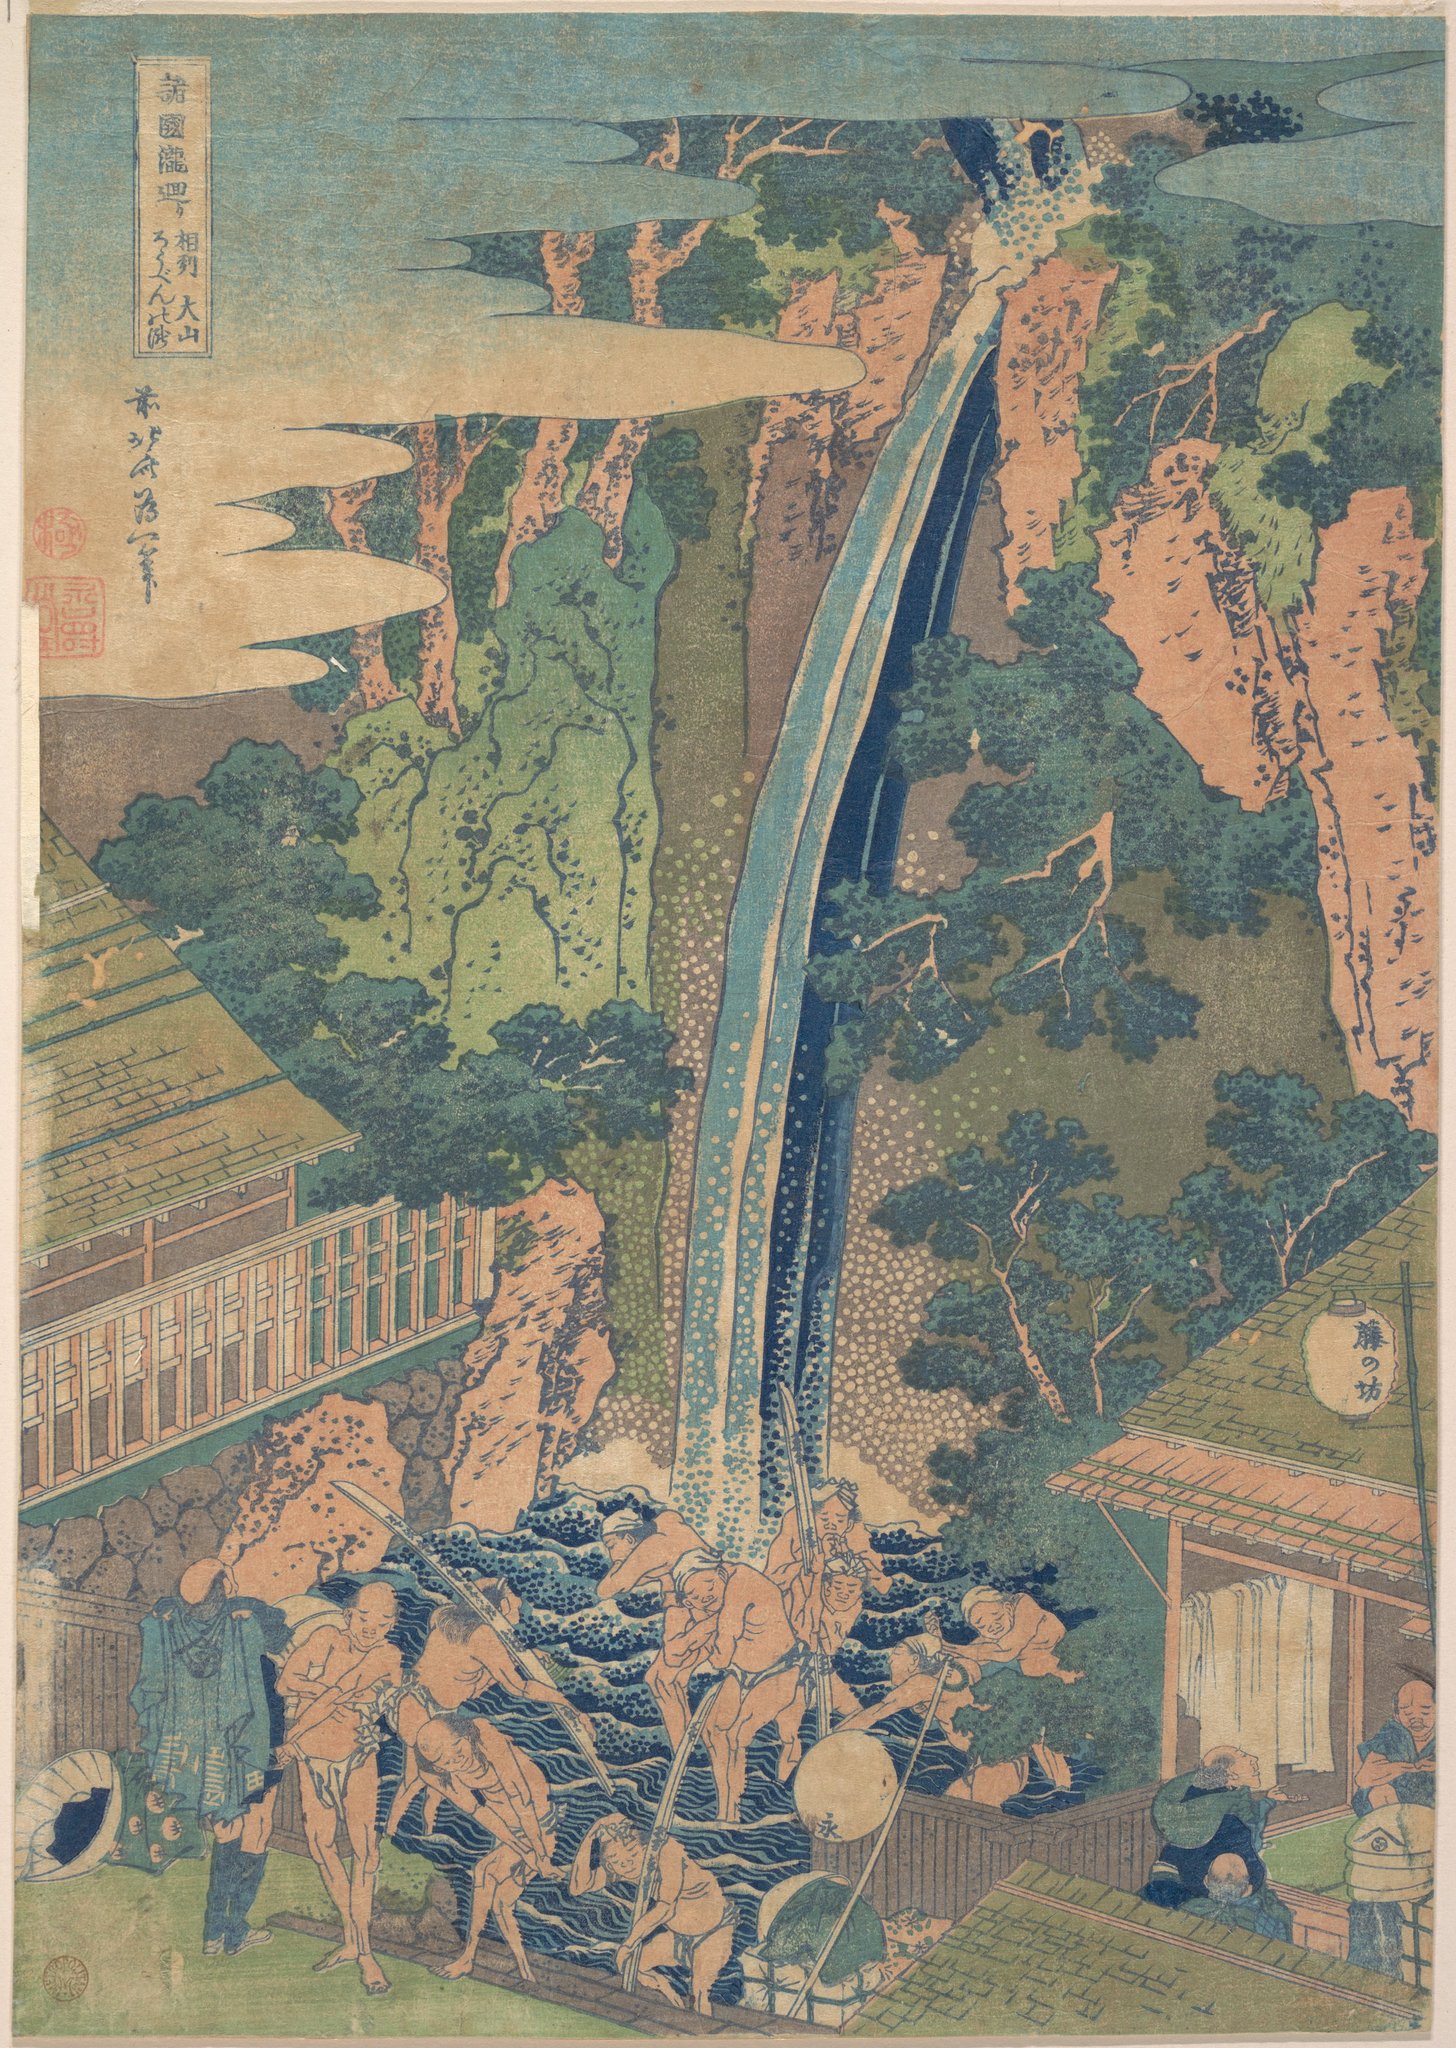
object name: woodblock print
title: Rōben Waterfall at Ōyama in Sagami Province (Sōshū Ōyama Rōben no taki), from the series A Tour of Waterfalls in Various Provinces (Shokoku taki meguri)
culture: japanese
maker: katsushika hokusai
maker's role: artist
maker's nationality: japanese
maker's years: 1760-1849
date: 1827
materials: ink, paper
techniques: woodblock print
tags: men,waterfalls,trees